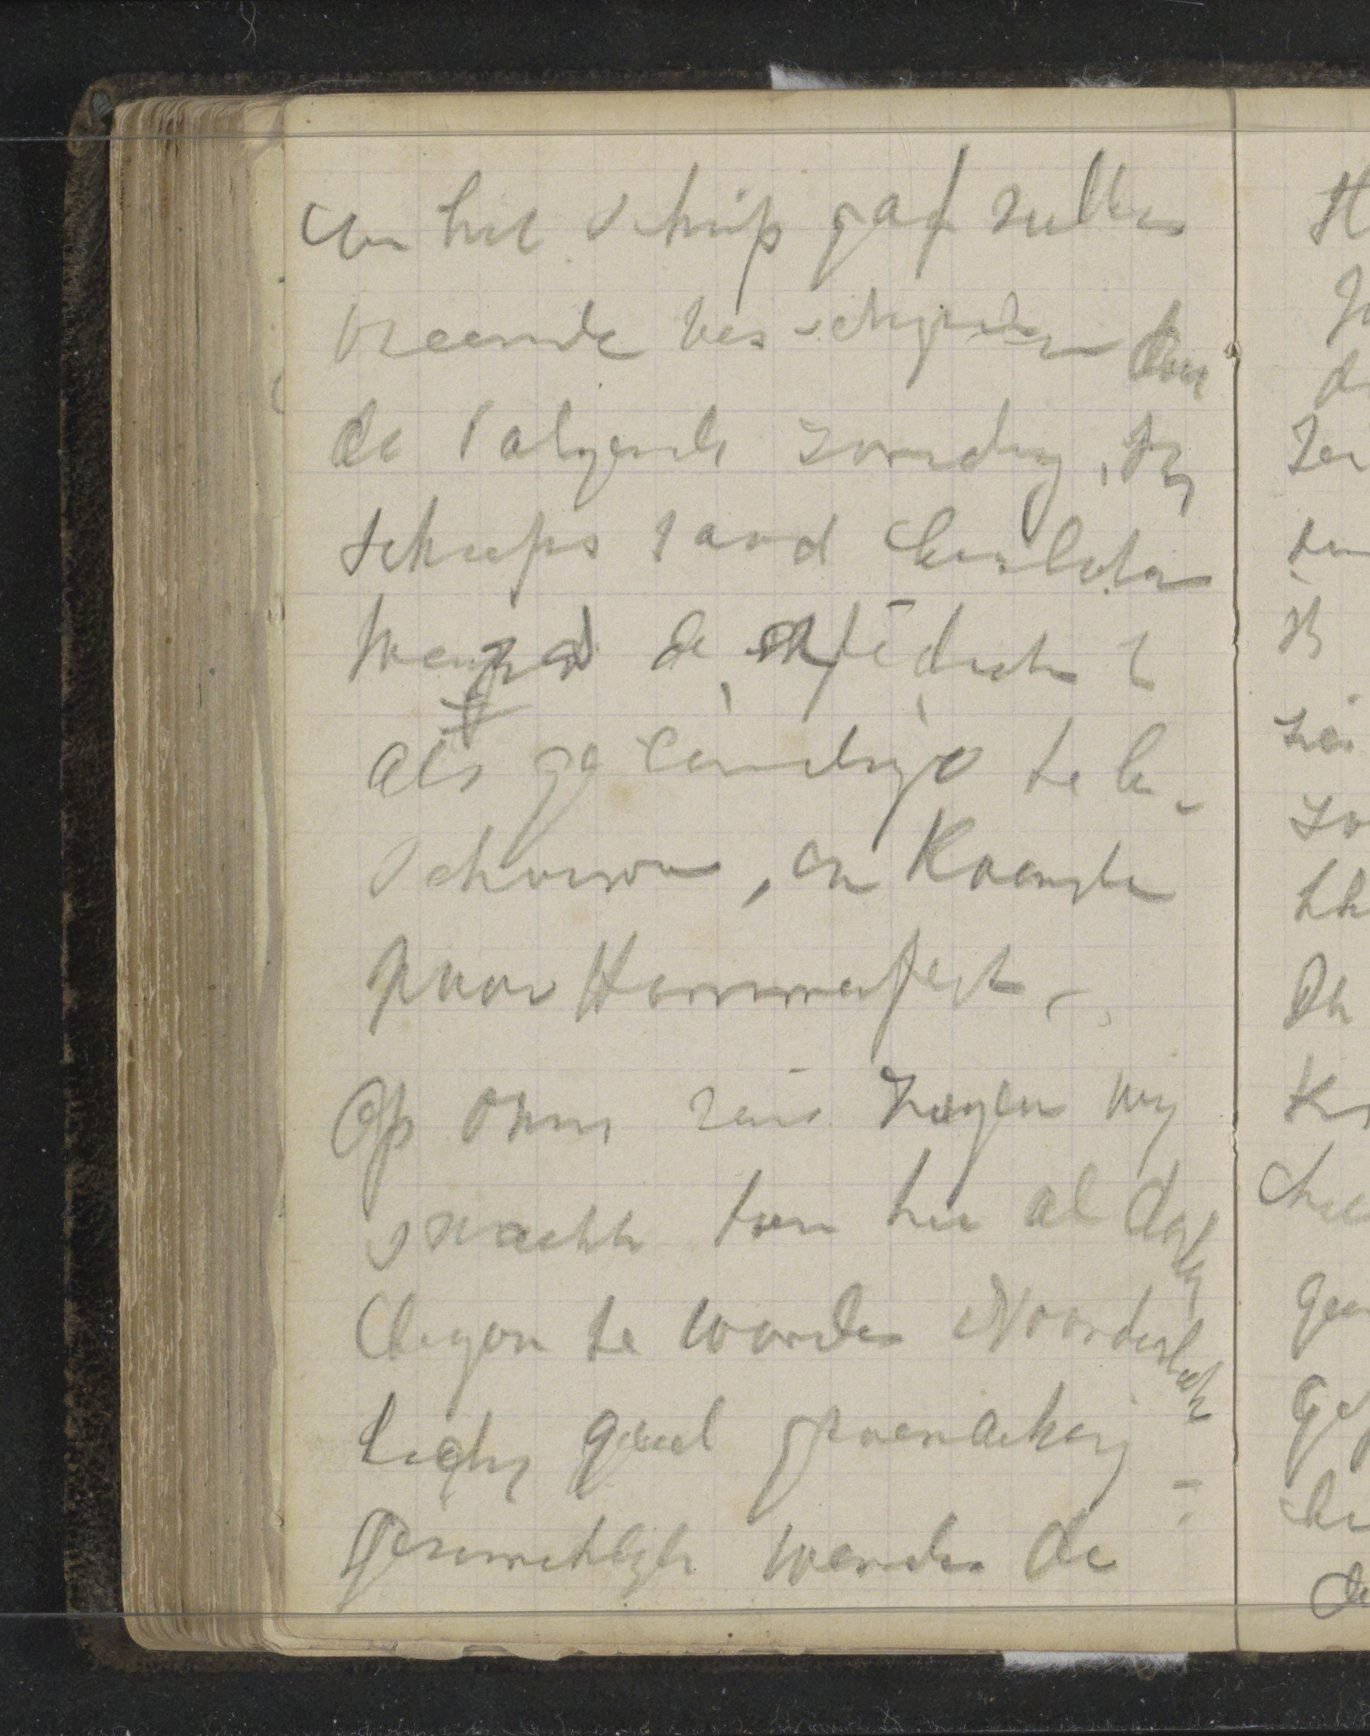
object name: sketchbook leaf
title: Reisverslag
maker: louis apol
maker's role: draughtsman, painter, print maker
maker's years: 1850-1936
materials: pencil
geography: novaya zemlya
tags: nova zembla expedities 1880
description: Blad 93 verso uit een schetsboek met 110 bladen betekend tijdens de expeditie naar Nova Zembla in 1880.